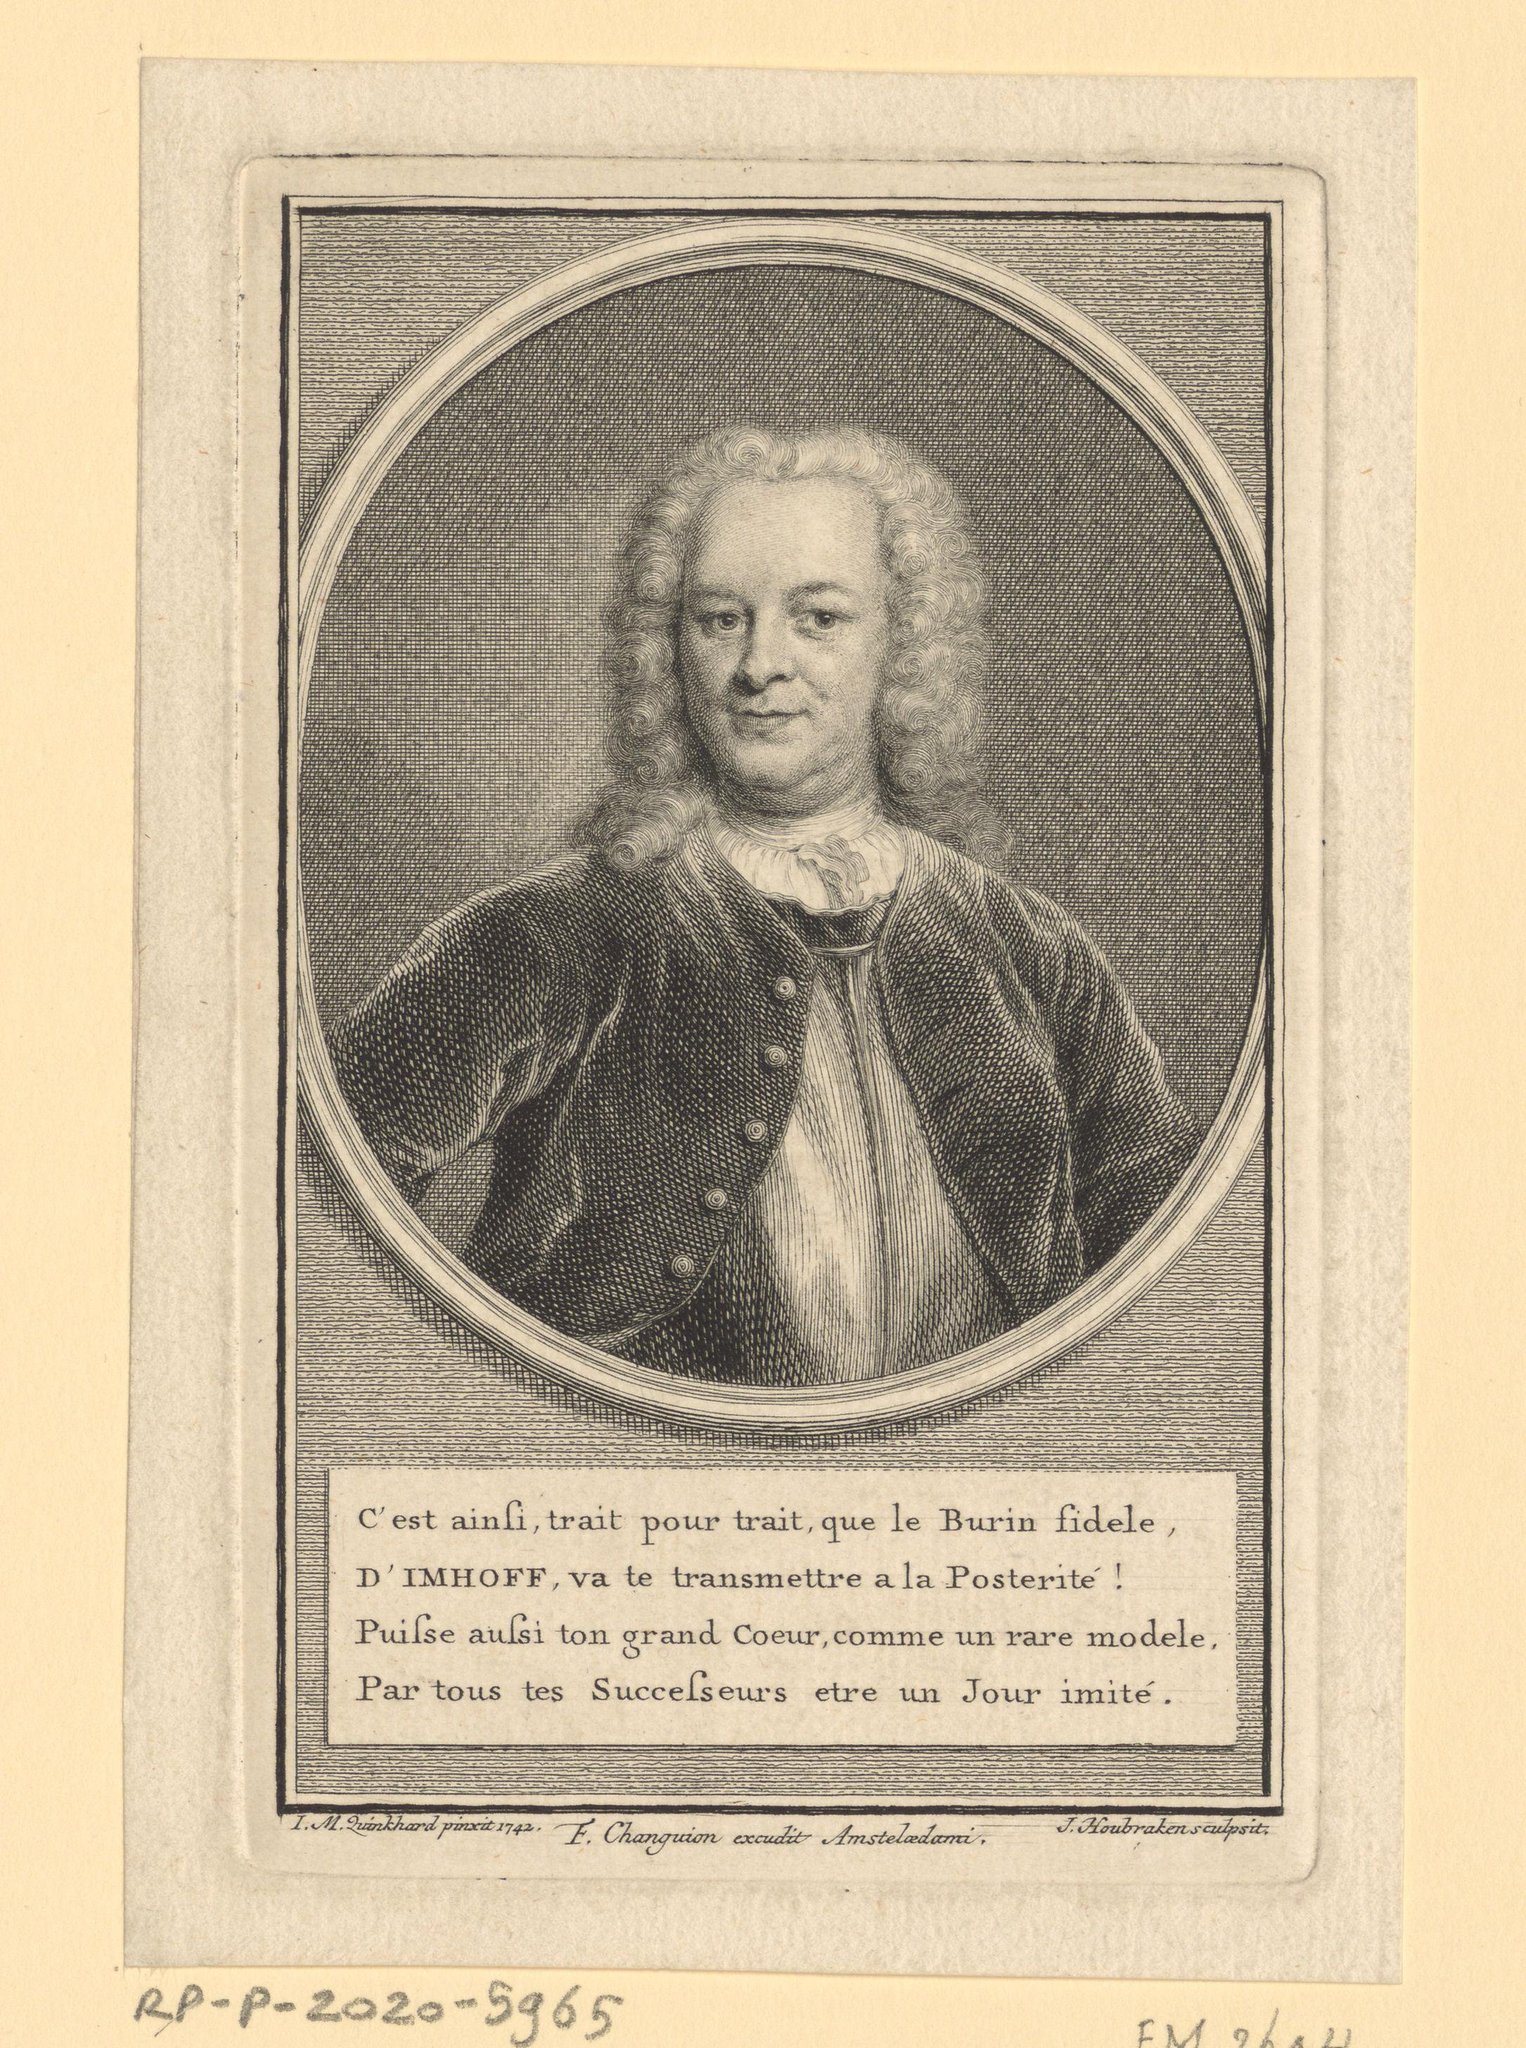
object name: print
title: Portret van baron Gustaaf Willem van Imhoff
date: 1742-1780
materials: paper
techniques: engraving, etching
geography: amsterdam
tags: batavia, colonial governor, historical persons